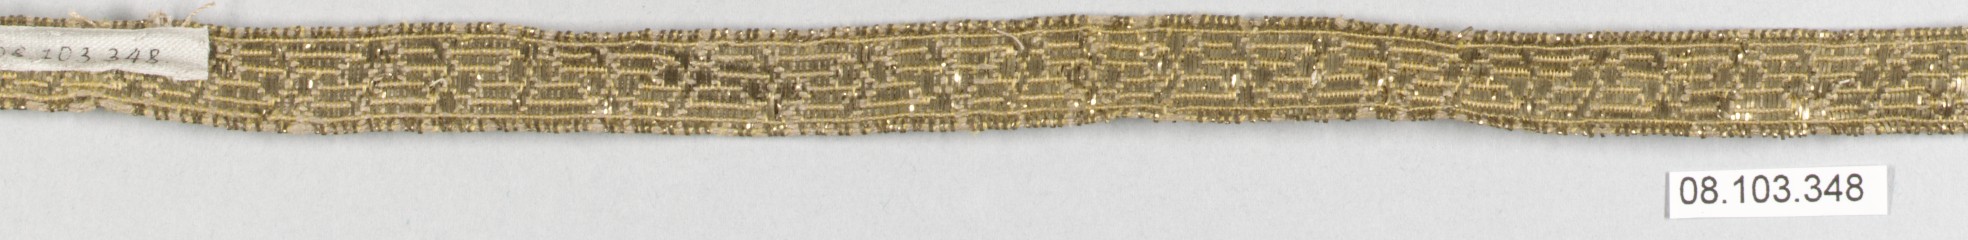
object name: galloon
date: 1601-1800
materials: metal thread